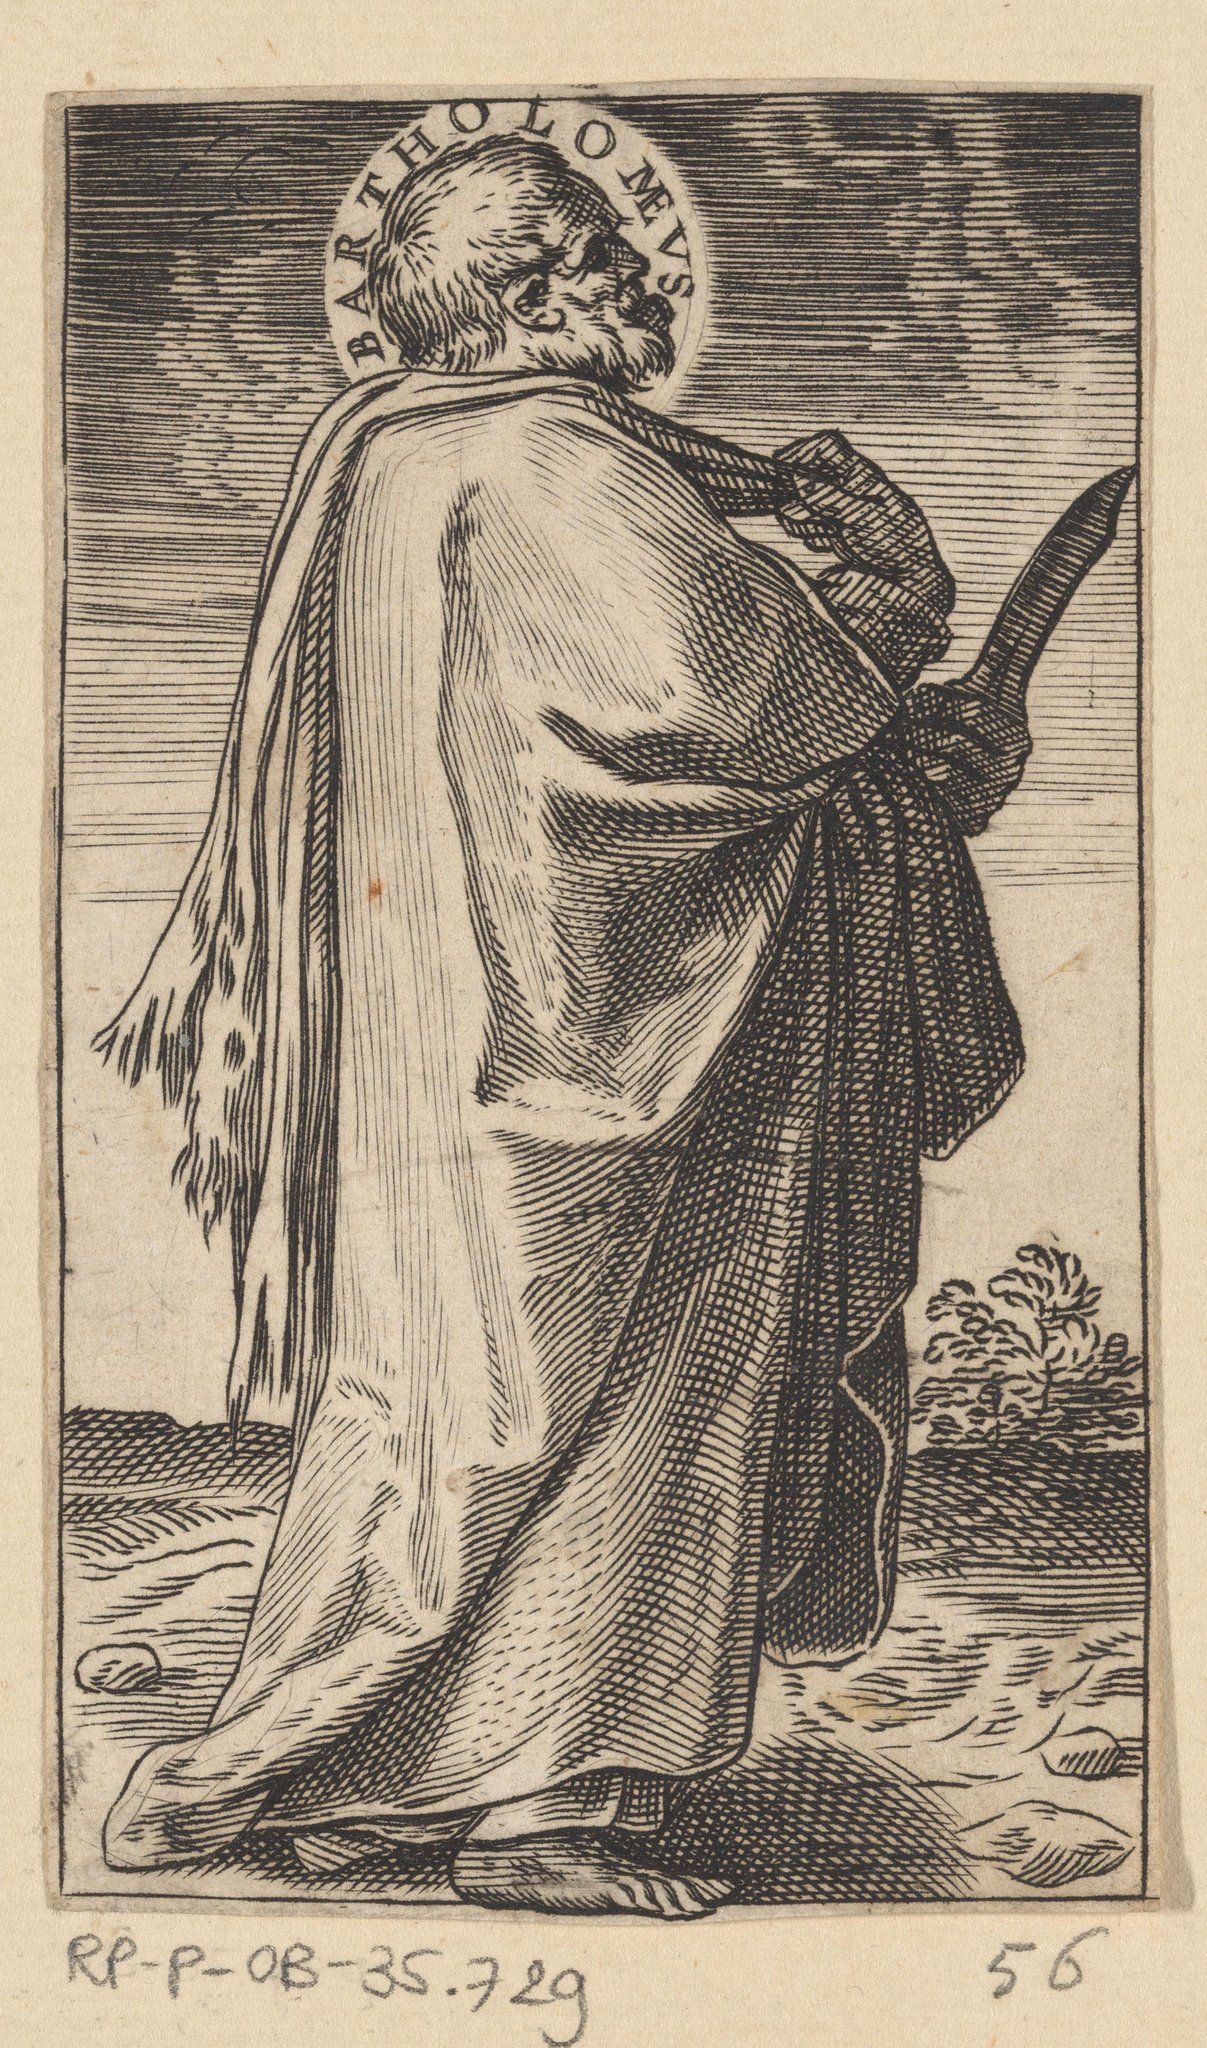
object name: print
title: Christus, Maria, Johannes de Doper en de apostelen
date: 1583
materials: paper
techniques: engraving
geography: italy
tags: the apostle bartholomew; possible attributes: book, devil or dragon at feet, knife, scroll, flayed skin, staff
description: Afbeelding gesneden uit een blad met drie voorstellingen van de apostelen Bartolomeüs met een mes, Tomas met een speer en Petrus met twee sleutels en een boek.